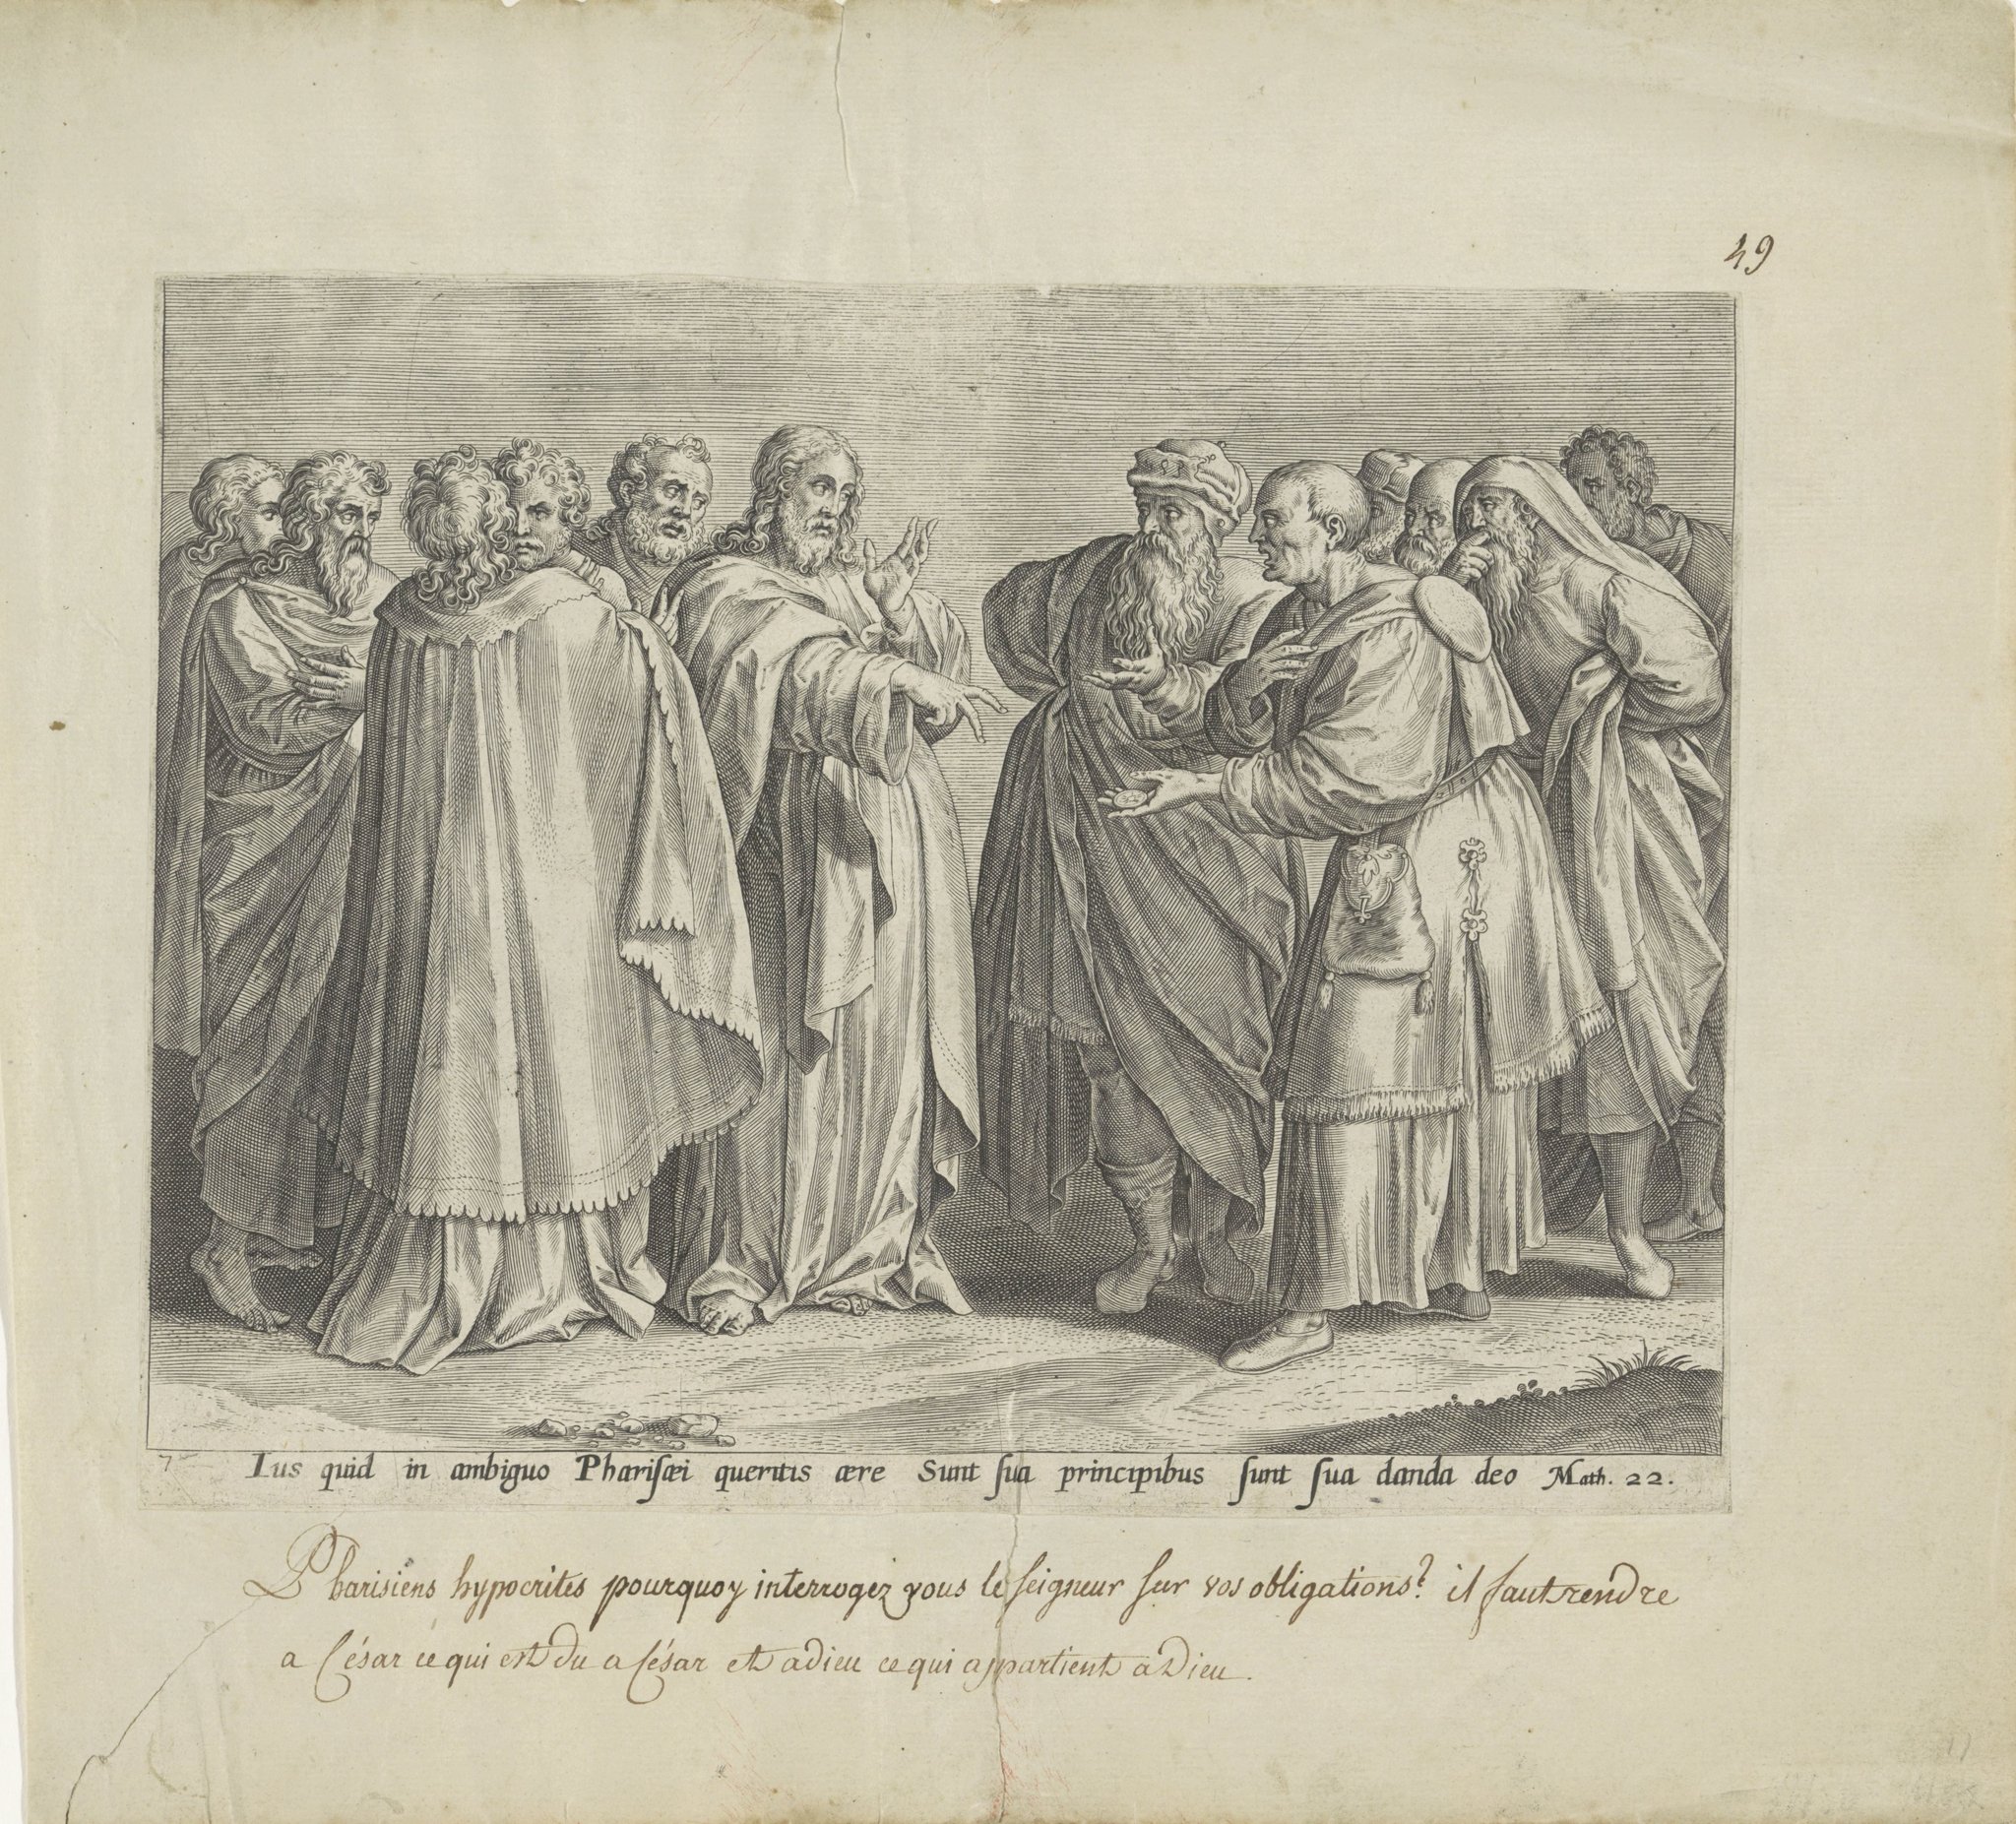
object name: print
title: Christus in debat met de farizeeën over de belasting aan de keizer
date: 1585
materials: paper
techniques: engraving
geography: antwerp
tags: christ (in the temple) in debate with pharisees about the tribute to caesar (matthew 22:15-22; mark 12:13-17; luke 20:20-26)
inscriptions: collector's mark: Lugt 2228, number: ‘49’, inscription: ‘Pharisiens hypocrites pourquoy interrogez vous le seigneur sur vos obligations? il faut rendre a Cesar ce qui est du a Cesar et a dieu ce qui appartient a Dieu.’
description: Christus in debat met de farizeeën. Achter hem staan zijn leerlingen. Een van de farizeeën toont hem een munt en vraagt aan Christus of het toegestaan is belasting aan de keizer te betalen. Onder de voorstelling een verwijzing in het Latijn naar de Bijbeltekst in Mat. 22.